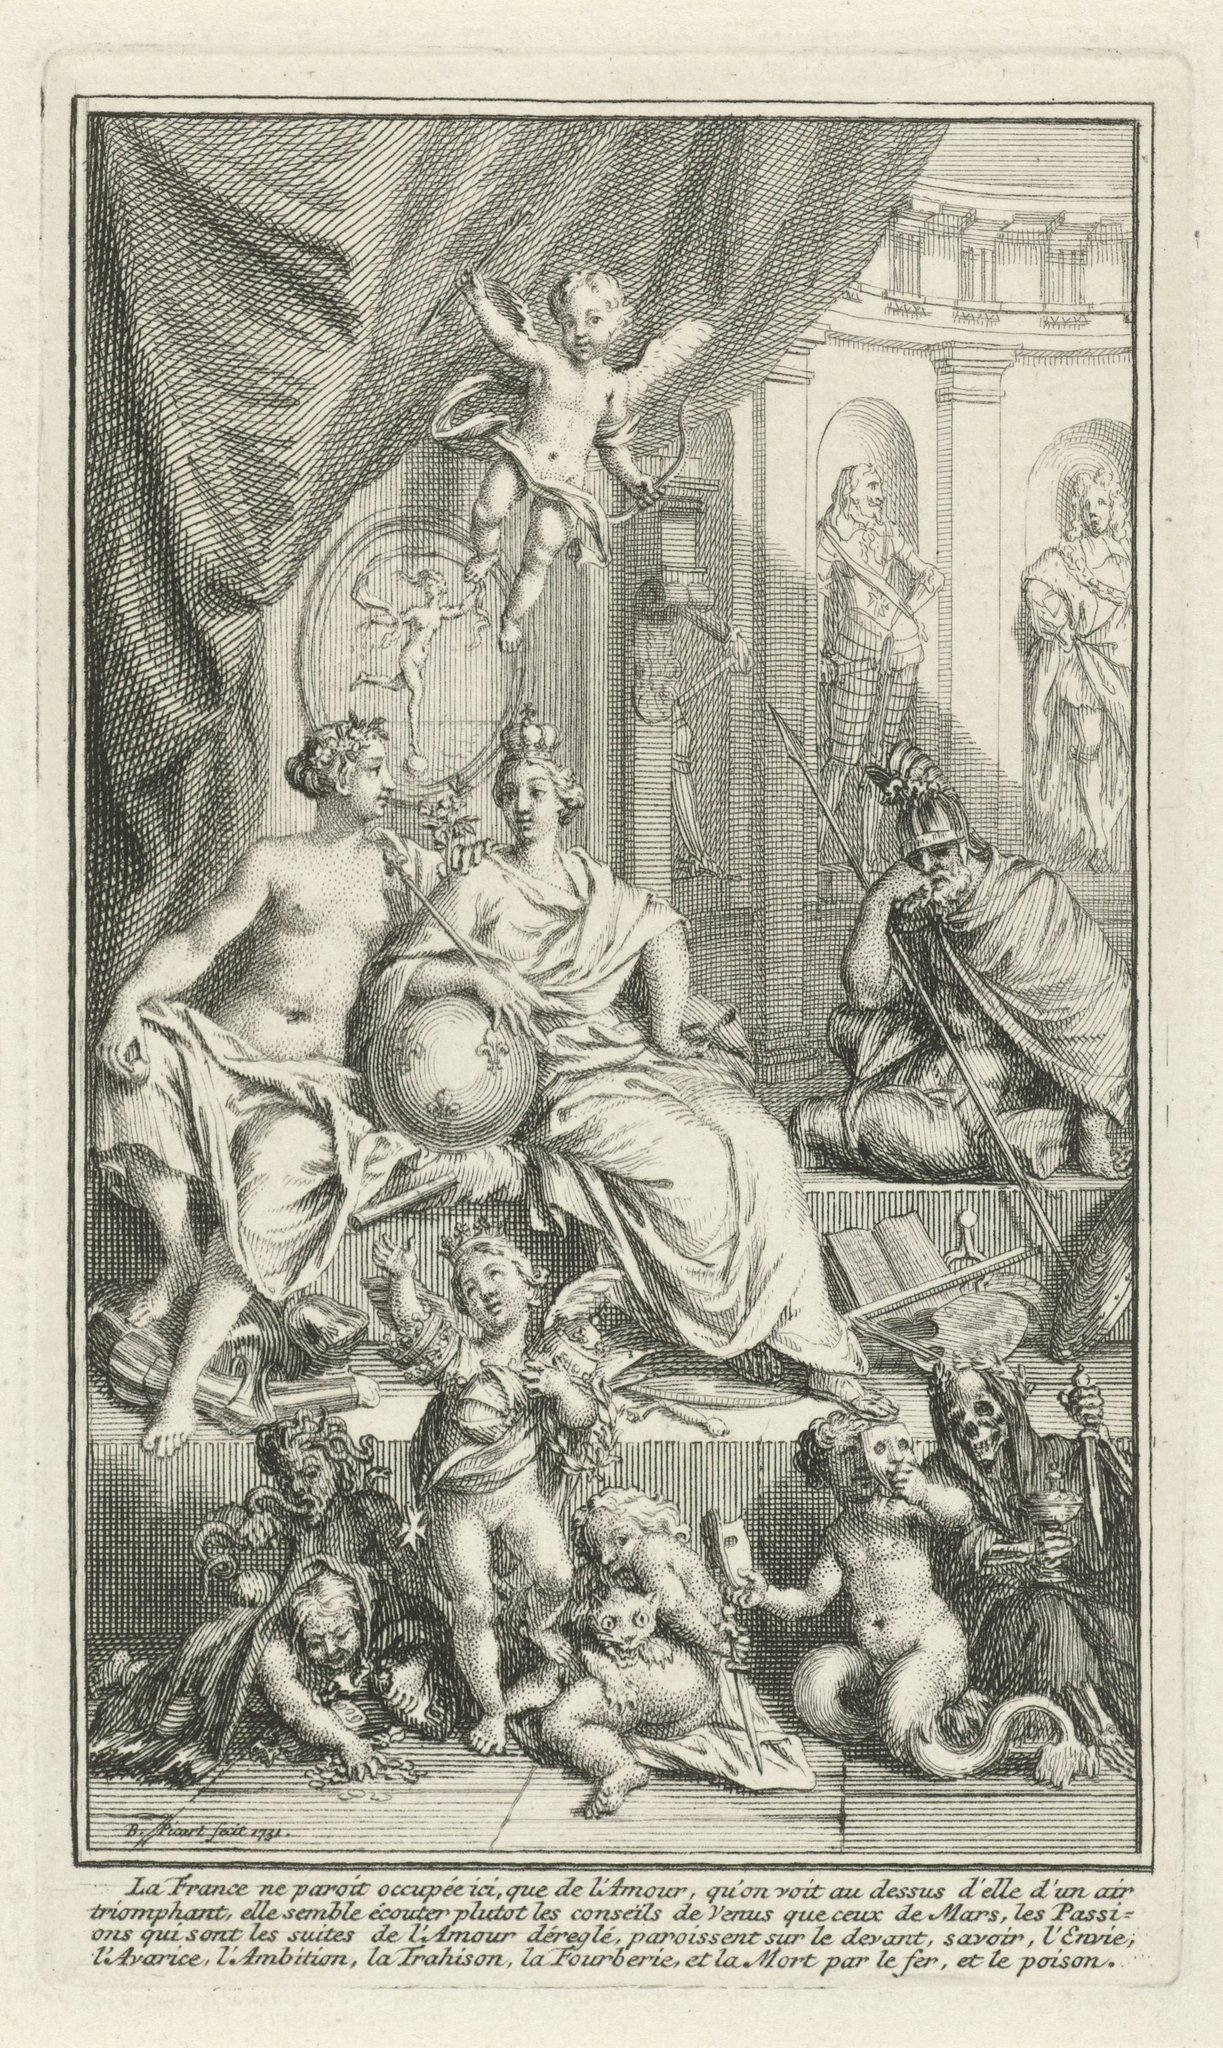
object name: titelblad, titelpagina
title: Allegorische titelpagina met de personificatie van Frankrijk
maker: bernard picart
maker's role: draughtsman, print maker, publisher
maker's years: 1673-1733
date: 1731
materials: paper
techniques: engraving, etching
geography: amsterdam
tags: (story of) mars (ares), 'passione d'amore' (ripa), personifications of countries, nations, states, districts, etc., (story of) cupid, amor (eros), (story of) venus (aphrodite)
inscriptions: collector's mark: Lugt 2233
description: De vrouwelijke personificatie van Frankrijk wordt vergezeld door Venus. Ze heeft zich afgekeerd van Mars die treurend op de achtergrond zit. Boven hen vliegt Amor. Op de voorgrond putti die de gevolgen van losbandige liefde symboliseren: Afgunst, Gierigheid, Verraad, Trouweloosheid en Dood. In de marge een vierregelig onderschrift in het Frans.